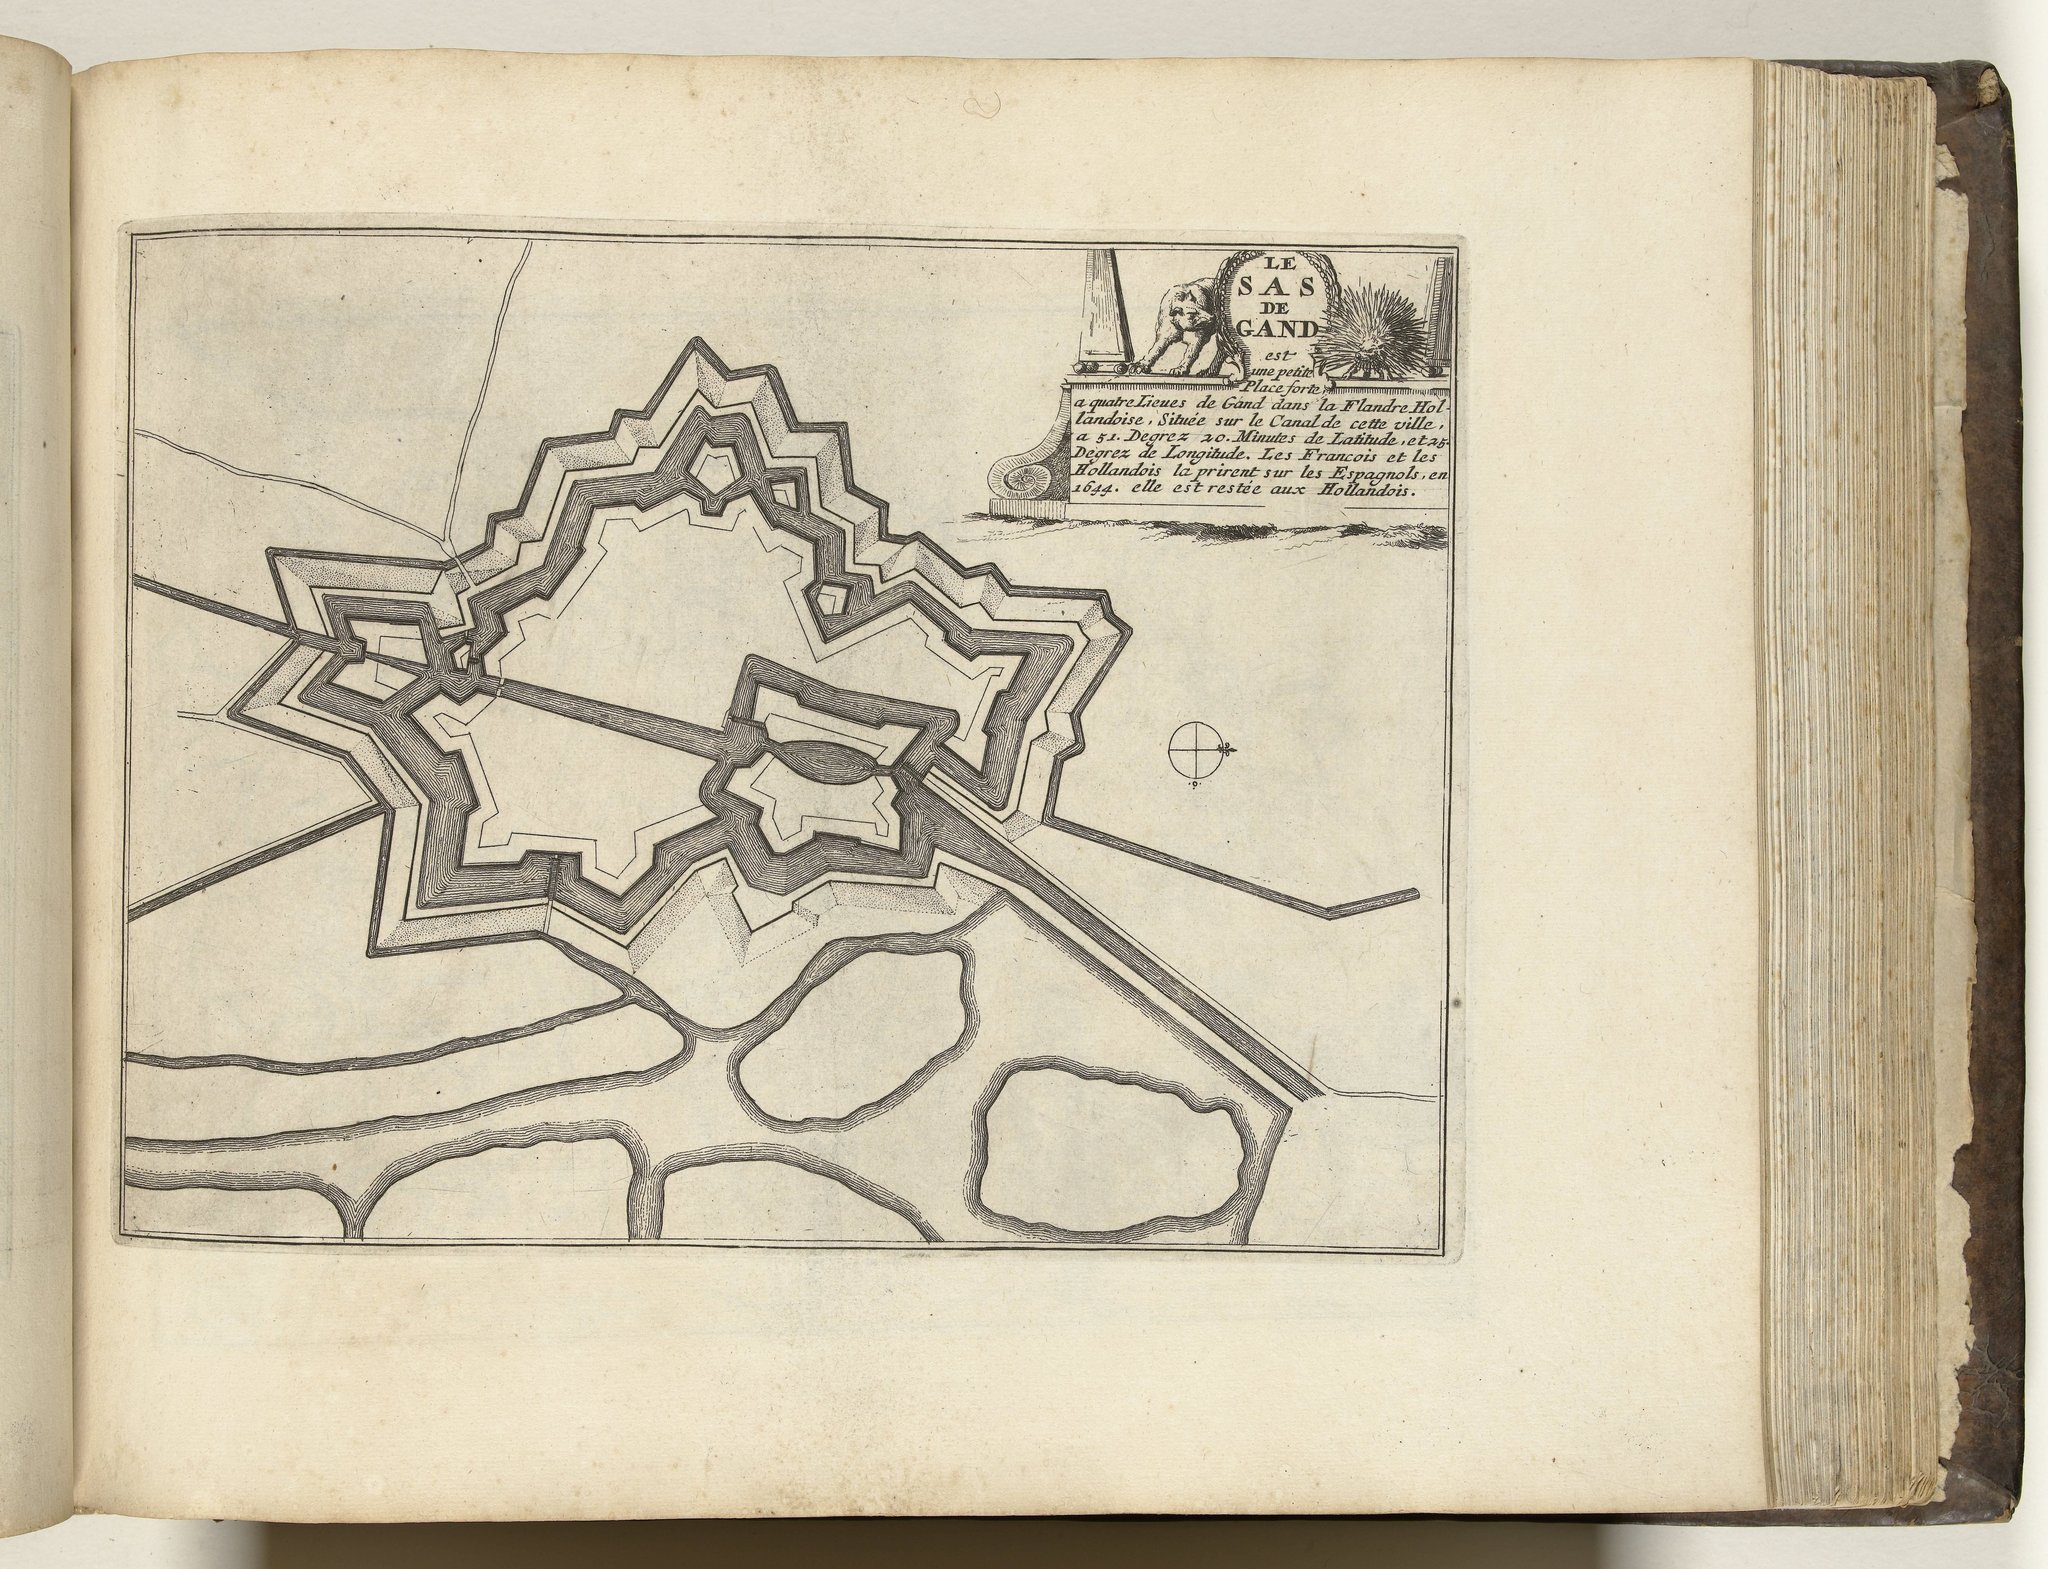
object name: area plan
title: Le Sas de Gand est une petite Place forte (...)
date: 1693-1696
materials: paper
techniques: etching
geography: paris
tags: fortified city, maps of cities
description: Plattegrond van de versterkingen om de Vlaamse stad Sas-van-Gent. Onderdeel van het vijfde deel (1696) van het prentwerk waarin gebundeld zijn de acht delen van Les forces de l'Europe uitgegeven tussen 1693-1697. Het prentwerk bestaat uit 175 platen met plannen (afkomstig van Sébastien Le Prestre, Seigneur de Vauban) van vermaarde sterke steden en vestingen in de Negenjarige Oorlog. Titel en opschriften in het Frans.